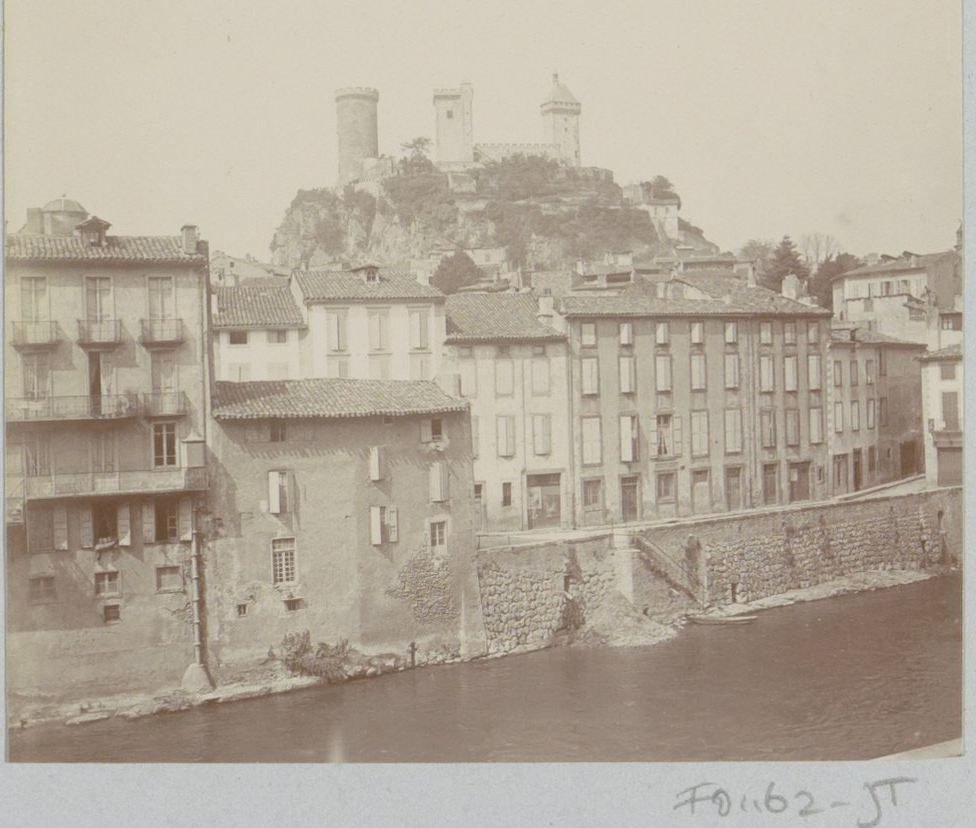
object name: photograph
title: Gezicht op huizen en het Kasteel van Foix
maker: Anonymous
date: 1905-1910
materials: paper, photographic support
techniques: gelatin silver print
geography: foix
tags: prospect of village, silhouette of village, castle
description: Onderdeel van Fotoalbum van een Franse amateurfotograaf met bezienswaardigheden in Frankrijk, Zwitserland en Italië.